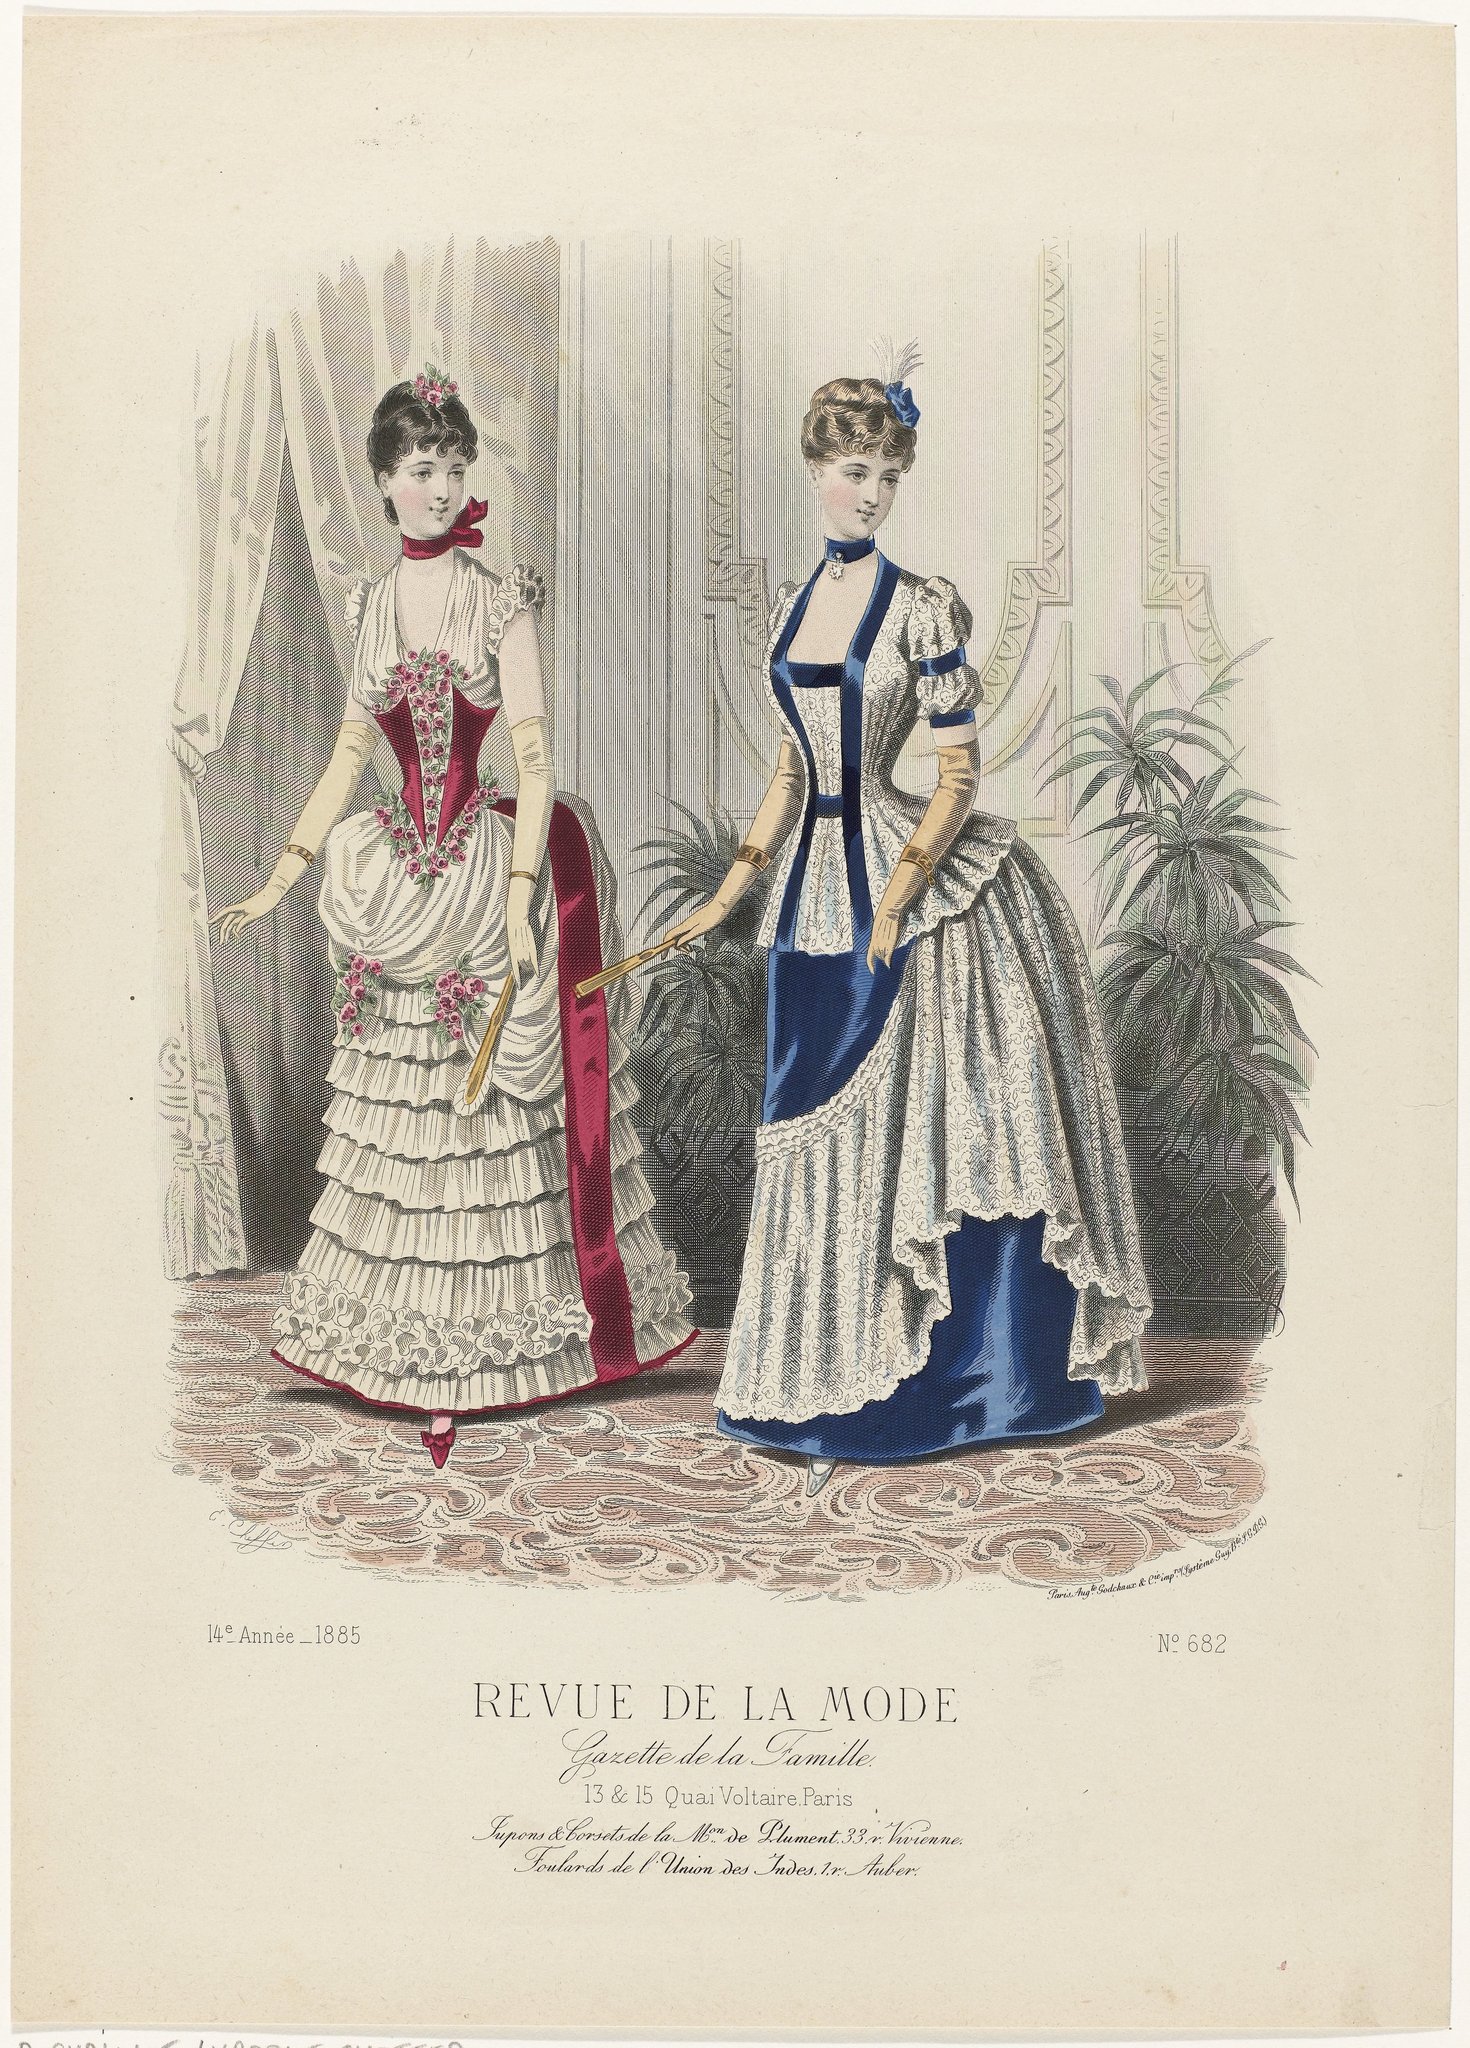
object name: fashion print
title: Revue de la Mode, Gazette de la Famille, dimanche 25 janvier 1885, 14e Année, No. 682: Jupons & Corsets (...)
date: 1885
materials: paper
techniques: engraving, hand coloring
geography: paris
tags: gloves, mittens (long gloves) (+ women's clothes), lace (+ women's clothes), flowers (+ variant), fashion plates, dress, gown (+ women's clothes), fan (+ women's clothes), bracelet, wristlet (+ women's clothes), necklace (+ women's clothes)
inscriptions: caption: ‘Jupons & Corsets de la M.on de Plument, 33, r. Vivienne. Foulards de l'Union des Indes, 1,r. Auber.’, title: ‘REVUE DE LA MODE / Gazette de la Famille’, address: ‘13 & 15, Quai Voltaire Paris’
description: Twee vrouwen in een interieur. Links: japon van witte mousseline, rode 'ottoman' en rozen van stof, geschikt voor een jonge vrouw. Rechts: japon van blauw fluweel en wit kant. Onder de voorstelling enkele regels reclametekst voor verschillende producten. Prent uit het modetijdschrift Revue de la Mode (1872-1913). Uitgebreide beschrijving van de kleding op pagina 29 "PLANCHE COLORIÉE".